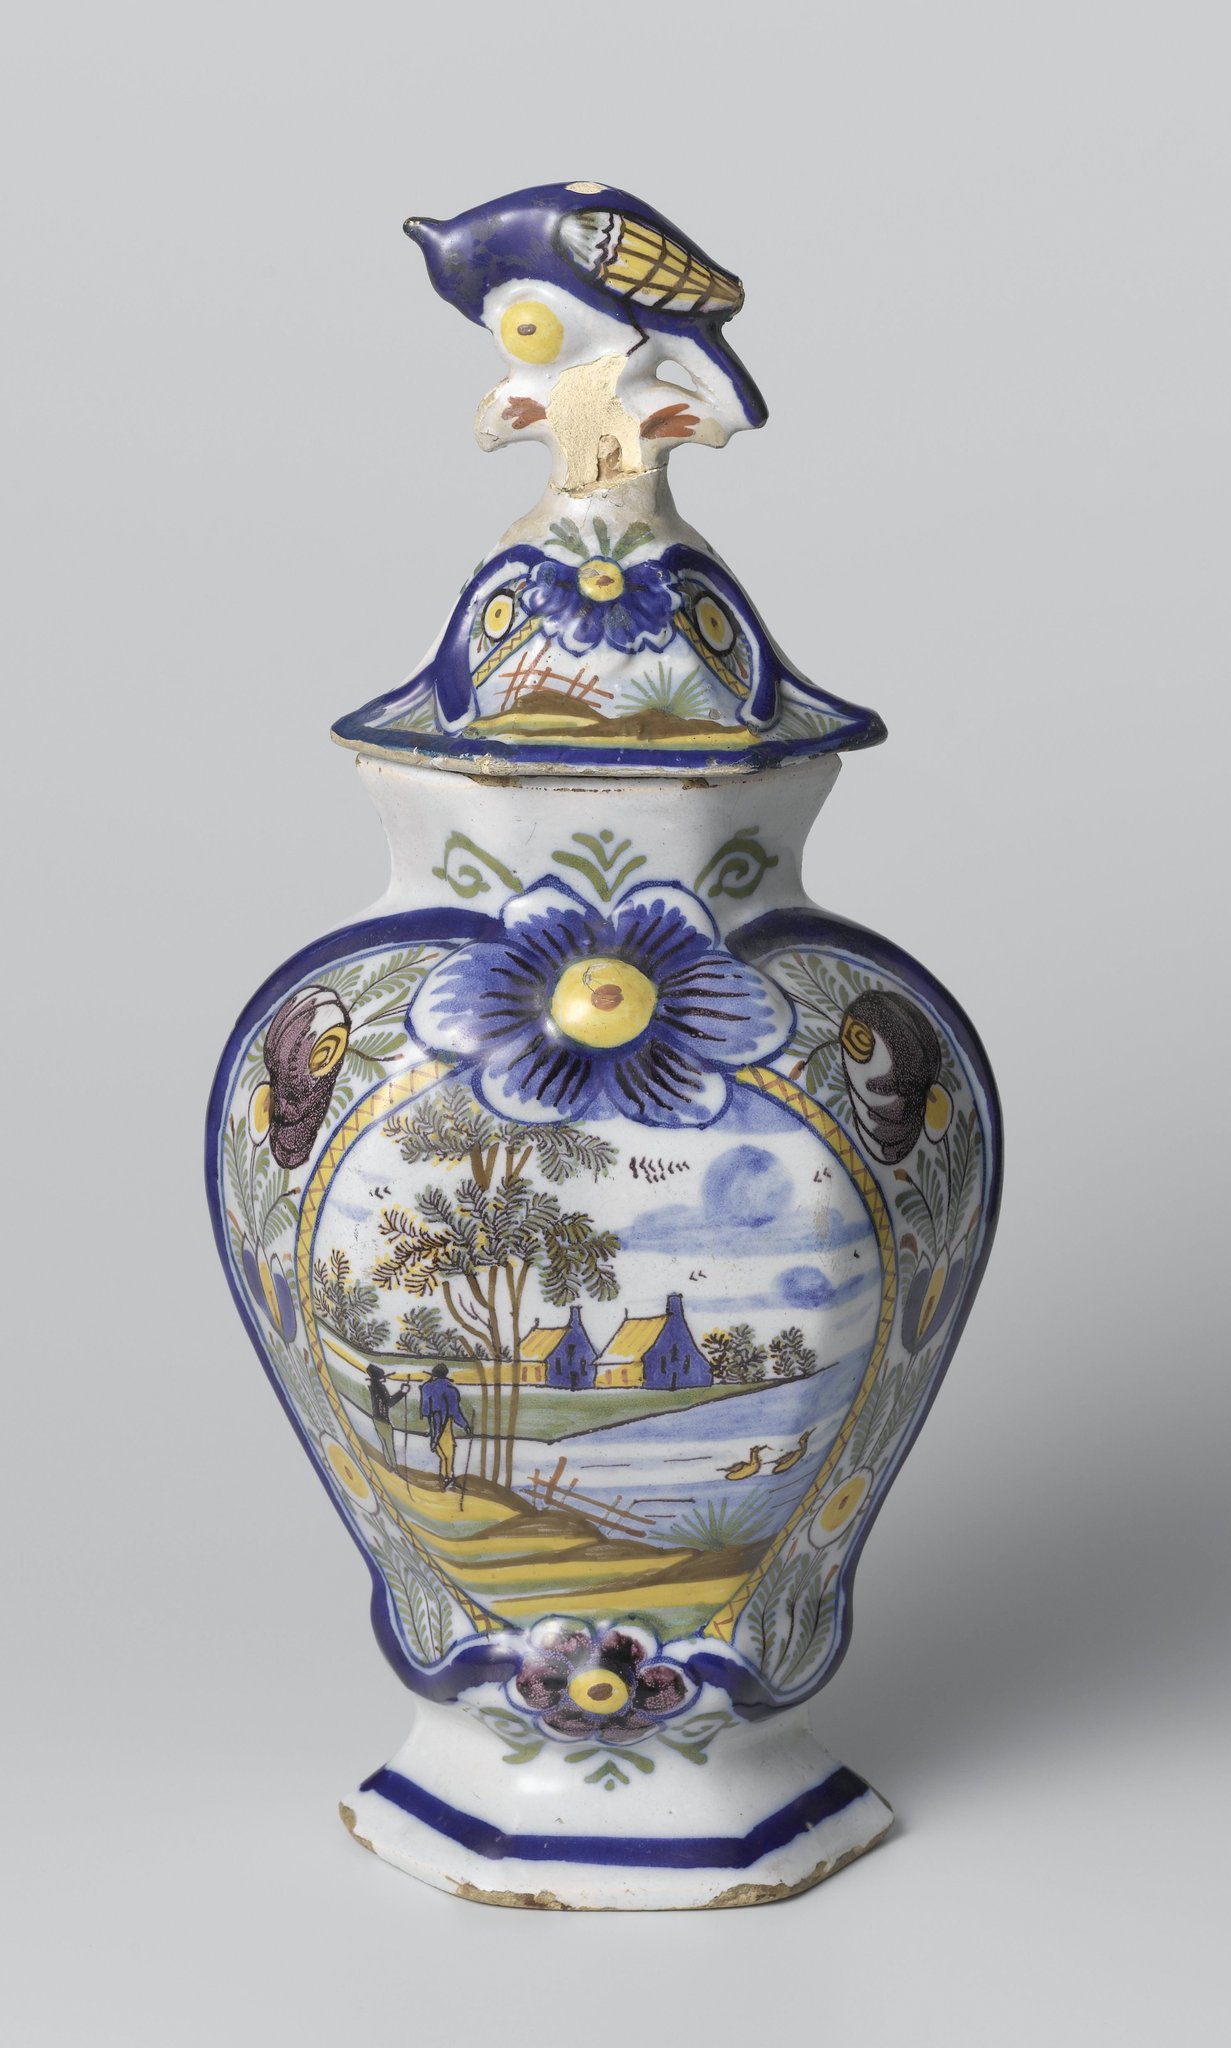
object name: covered jar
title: dekstelpot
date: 1810-1840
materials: earthenware, glaze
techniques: painted, polychromy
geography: delft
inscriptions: mark: ‘B:P’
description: Pot van veelkleurig beschilderde faience. Op de pot is een cartouche met daarbinnen twee huizen in een landschap in de kleuren blauw, geel, groen, bruin en paars geschilderd. De knop van het deksel is een in een vrucht pikkende vogel. De pot hoort bij een identieke pot en een beker.